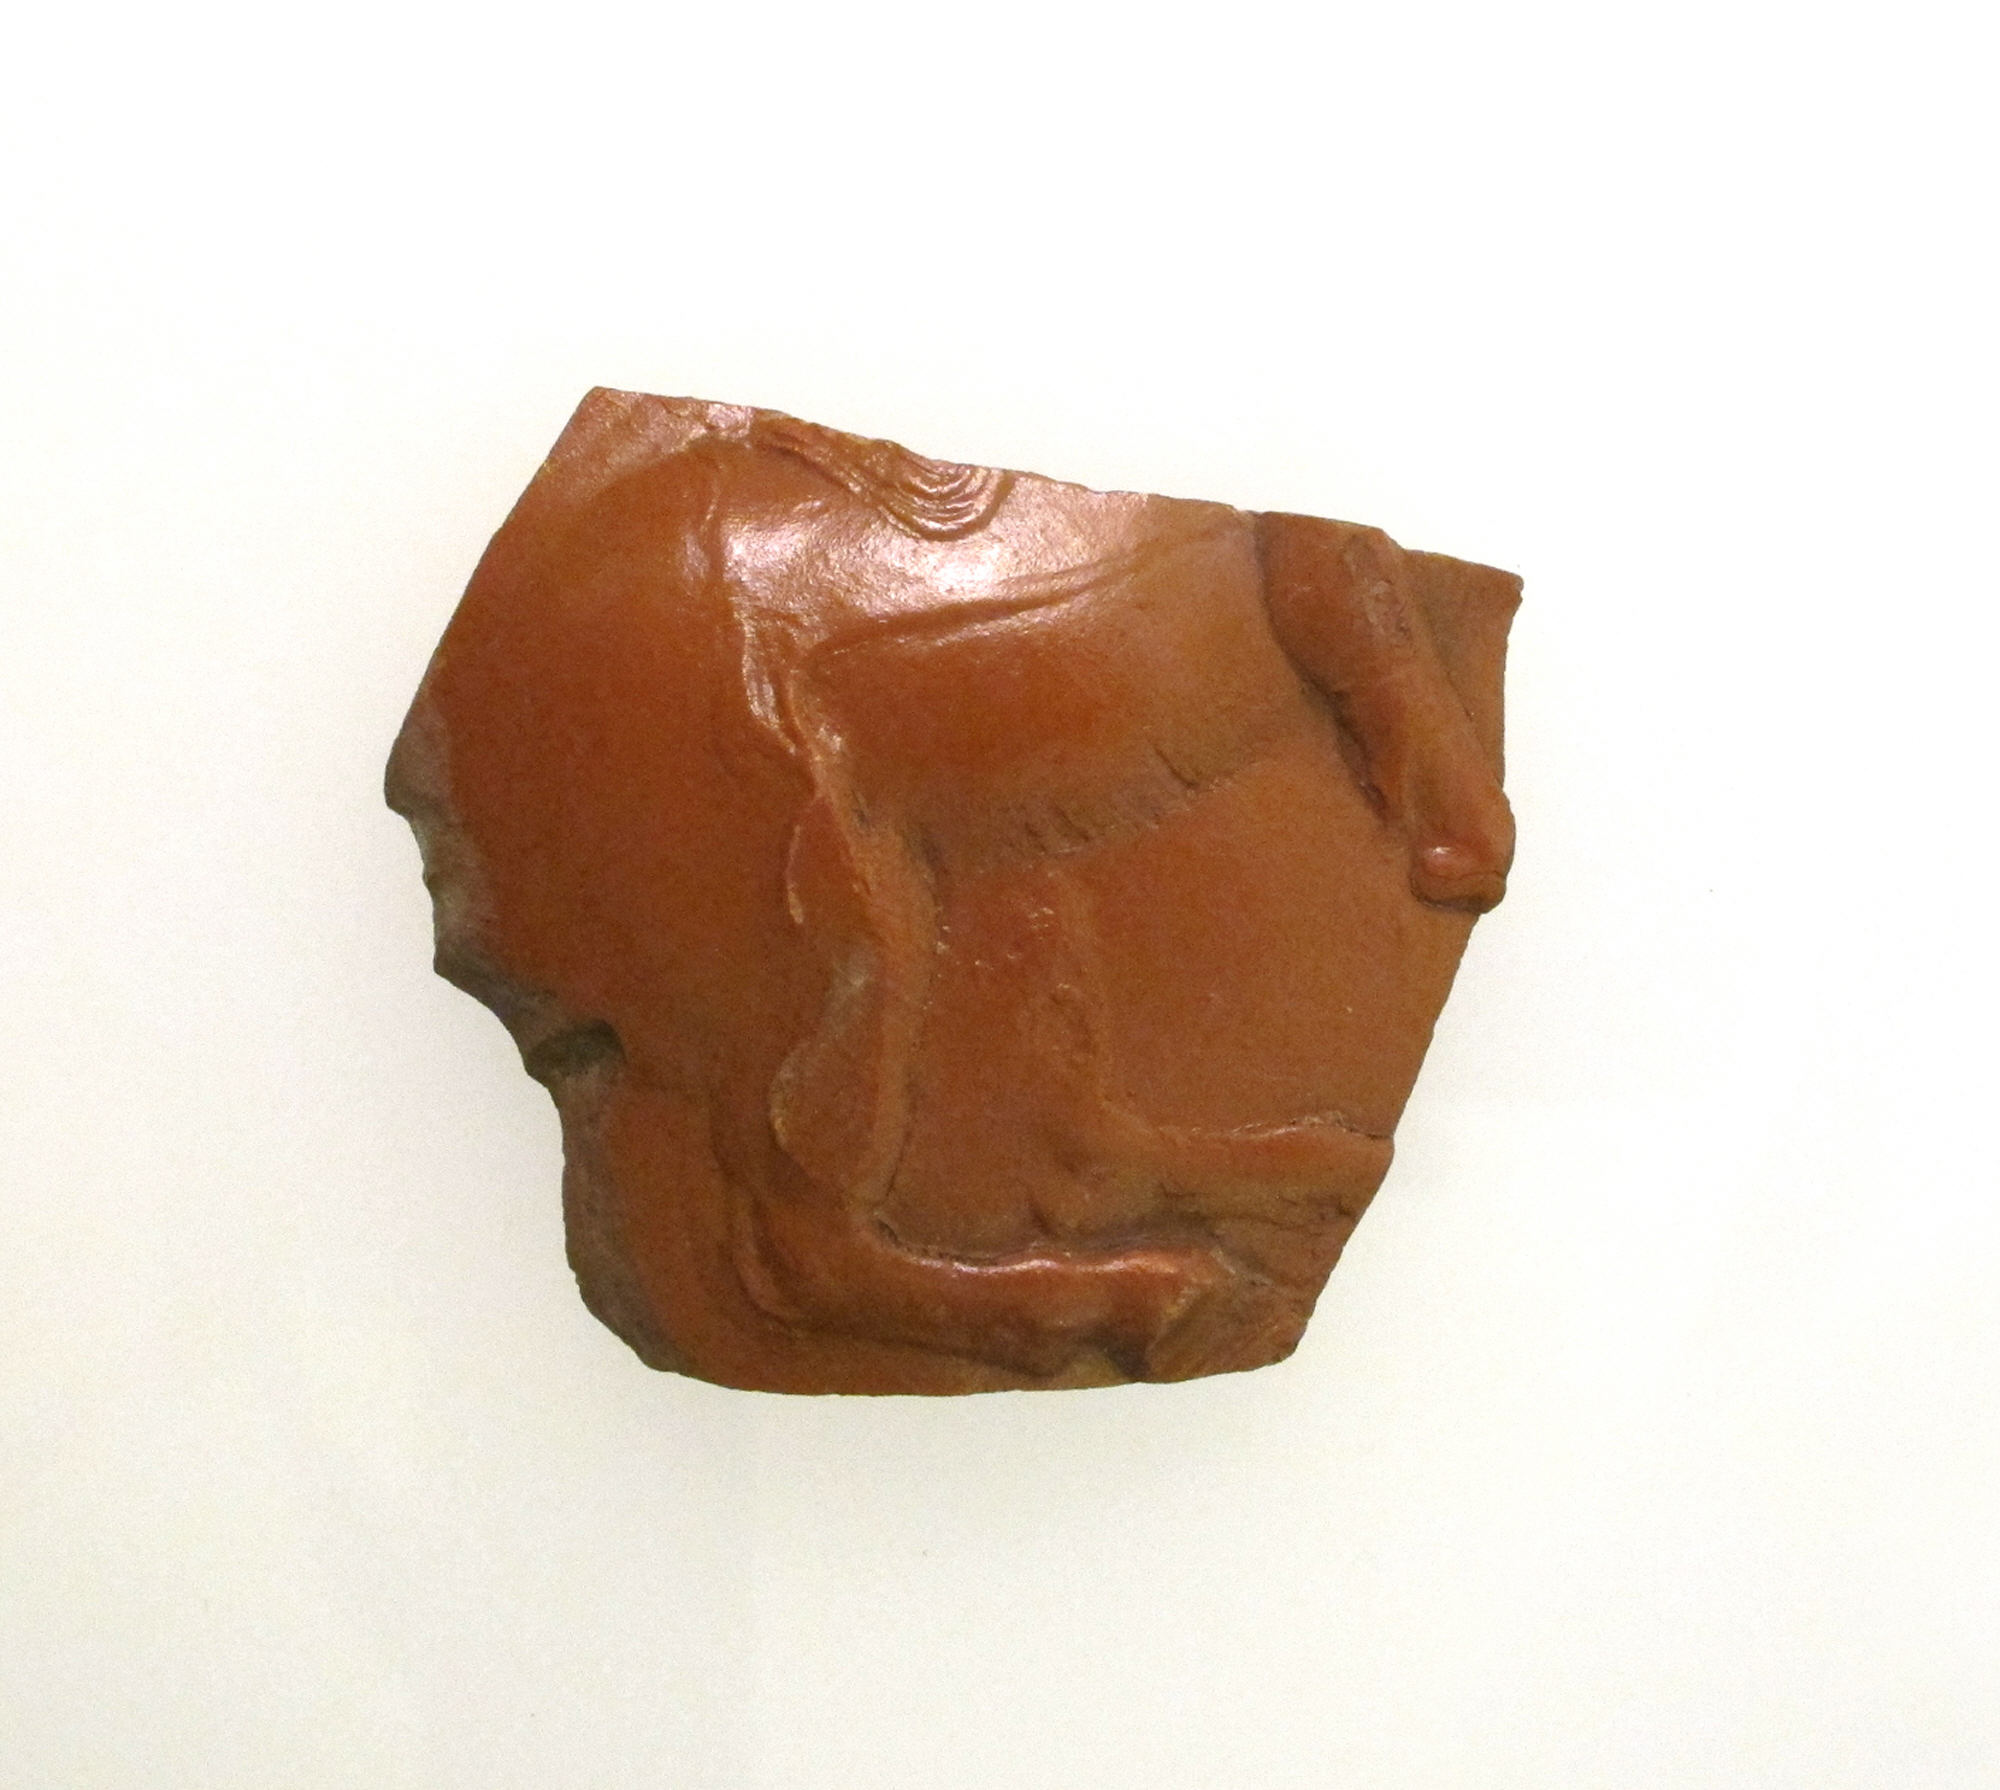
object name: vase fragment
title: Arretine ware fragment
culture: roman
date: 100 BCE-100 CE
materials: terracotta